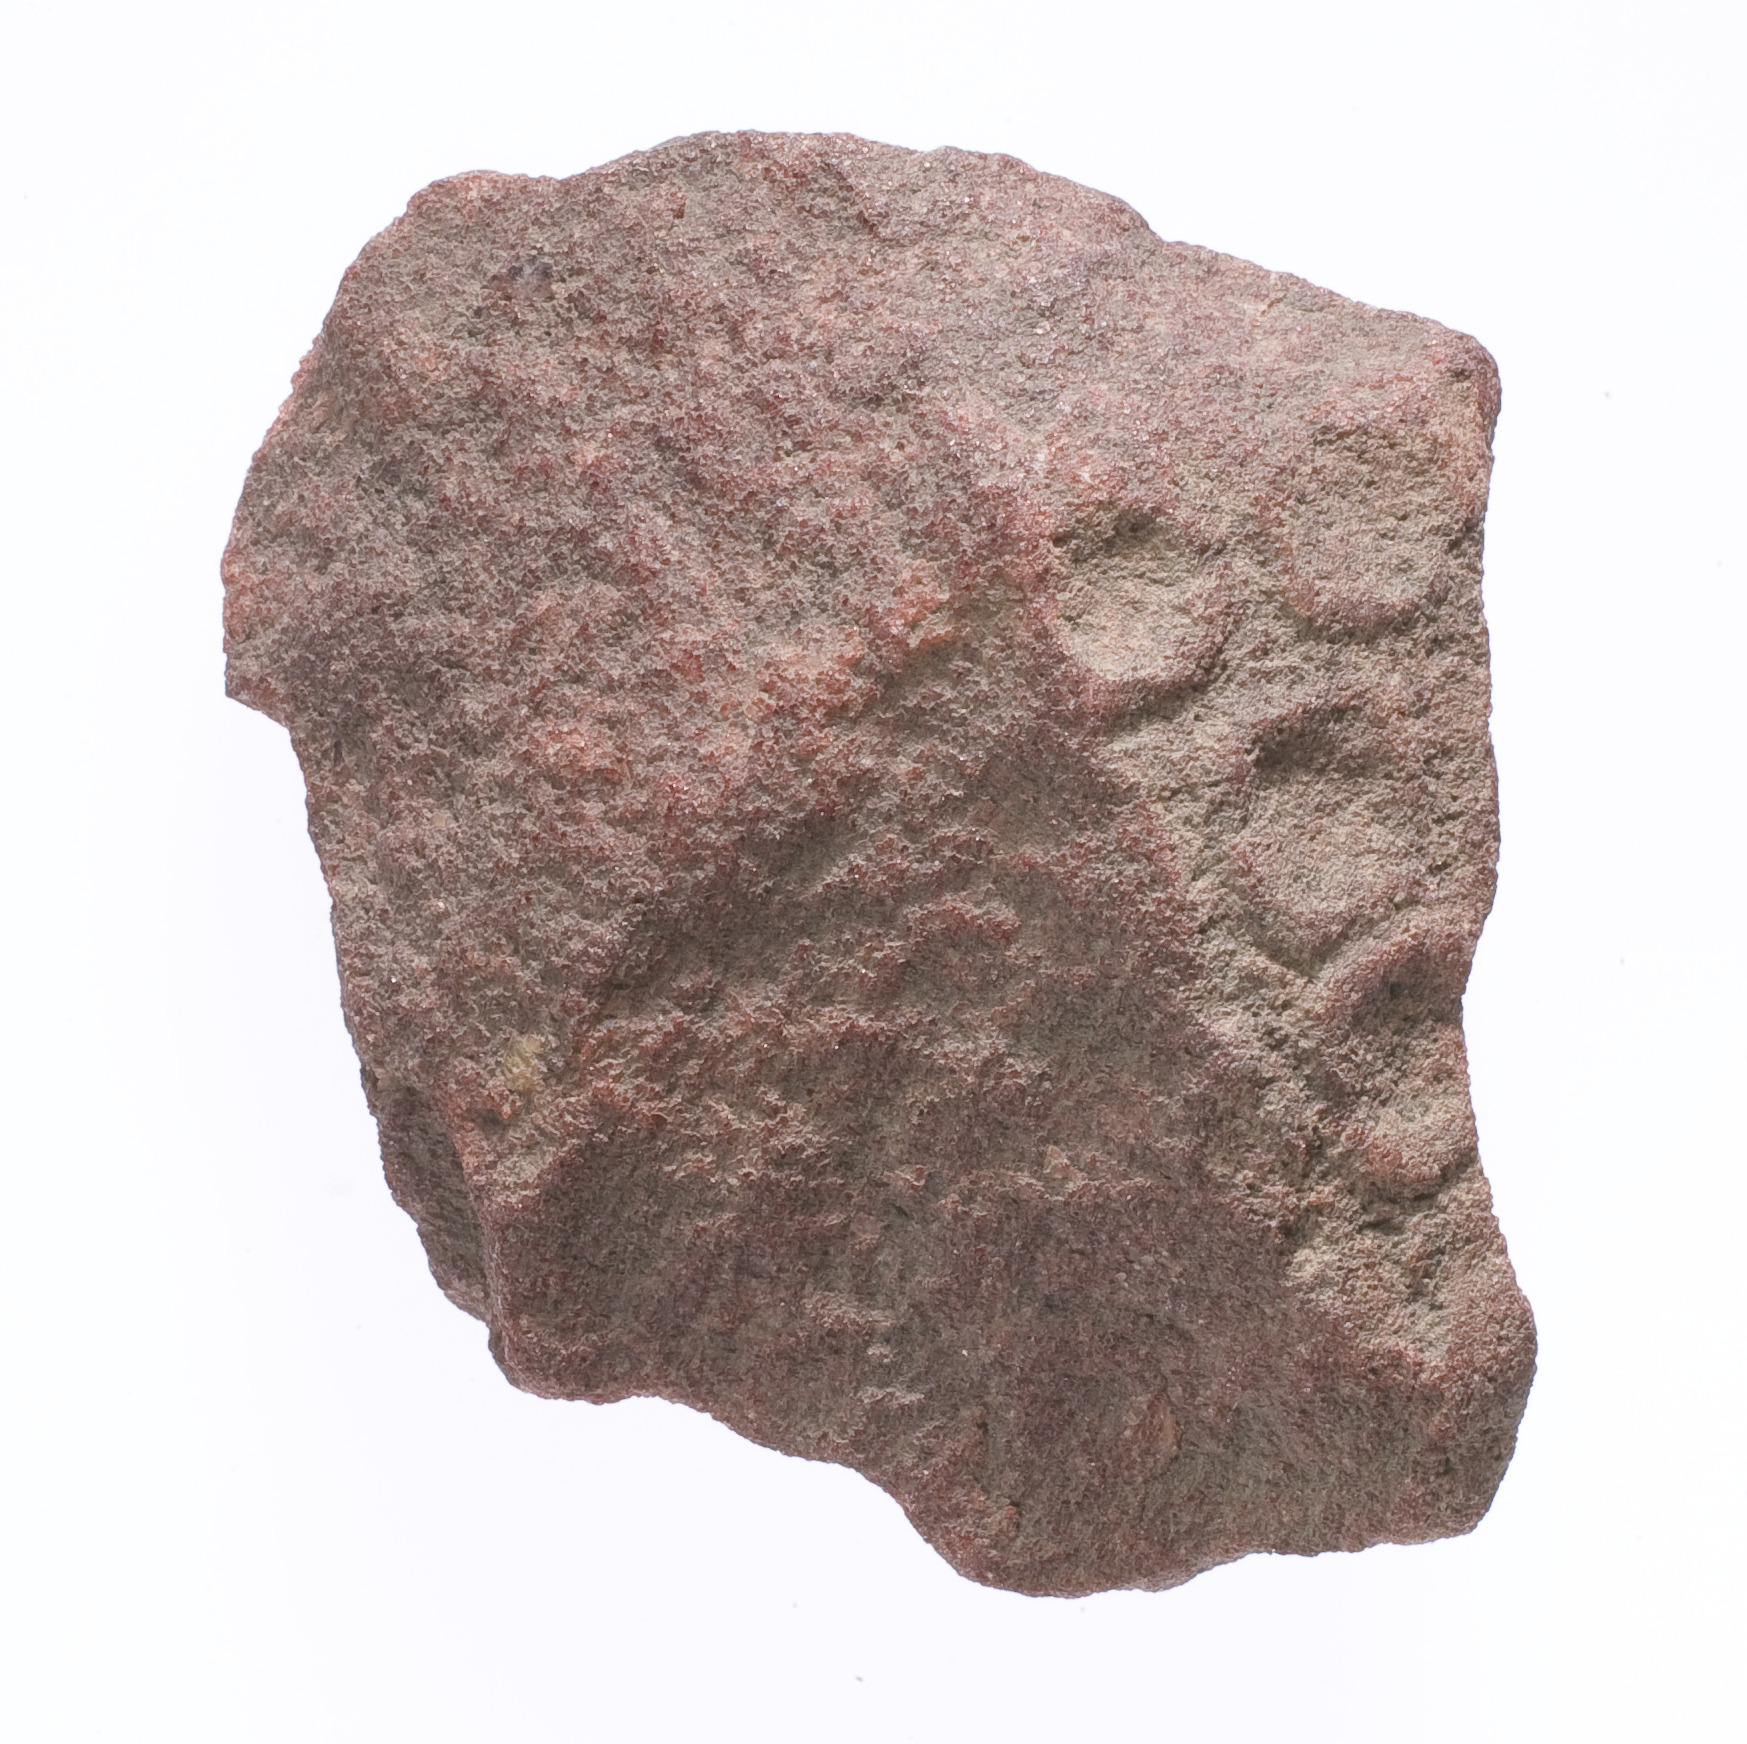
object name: crown with disc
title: Crown with discs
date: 1353-1336 BCE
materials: quartzite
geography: egypt